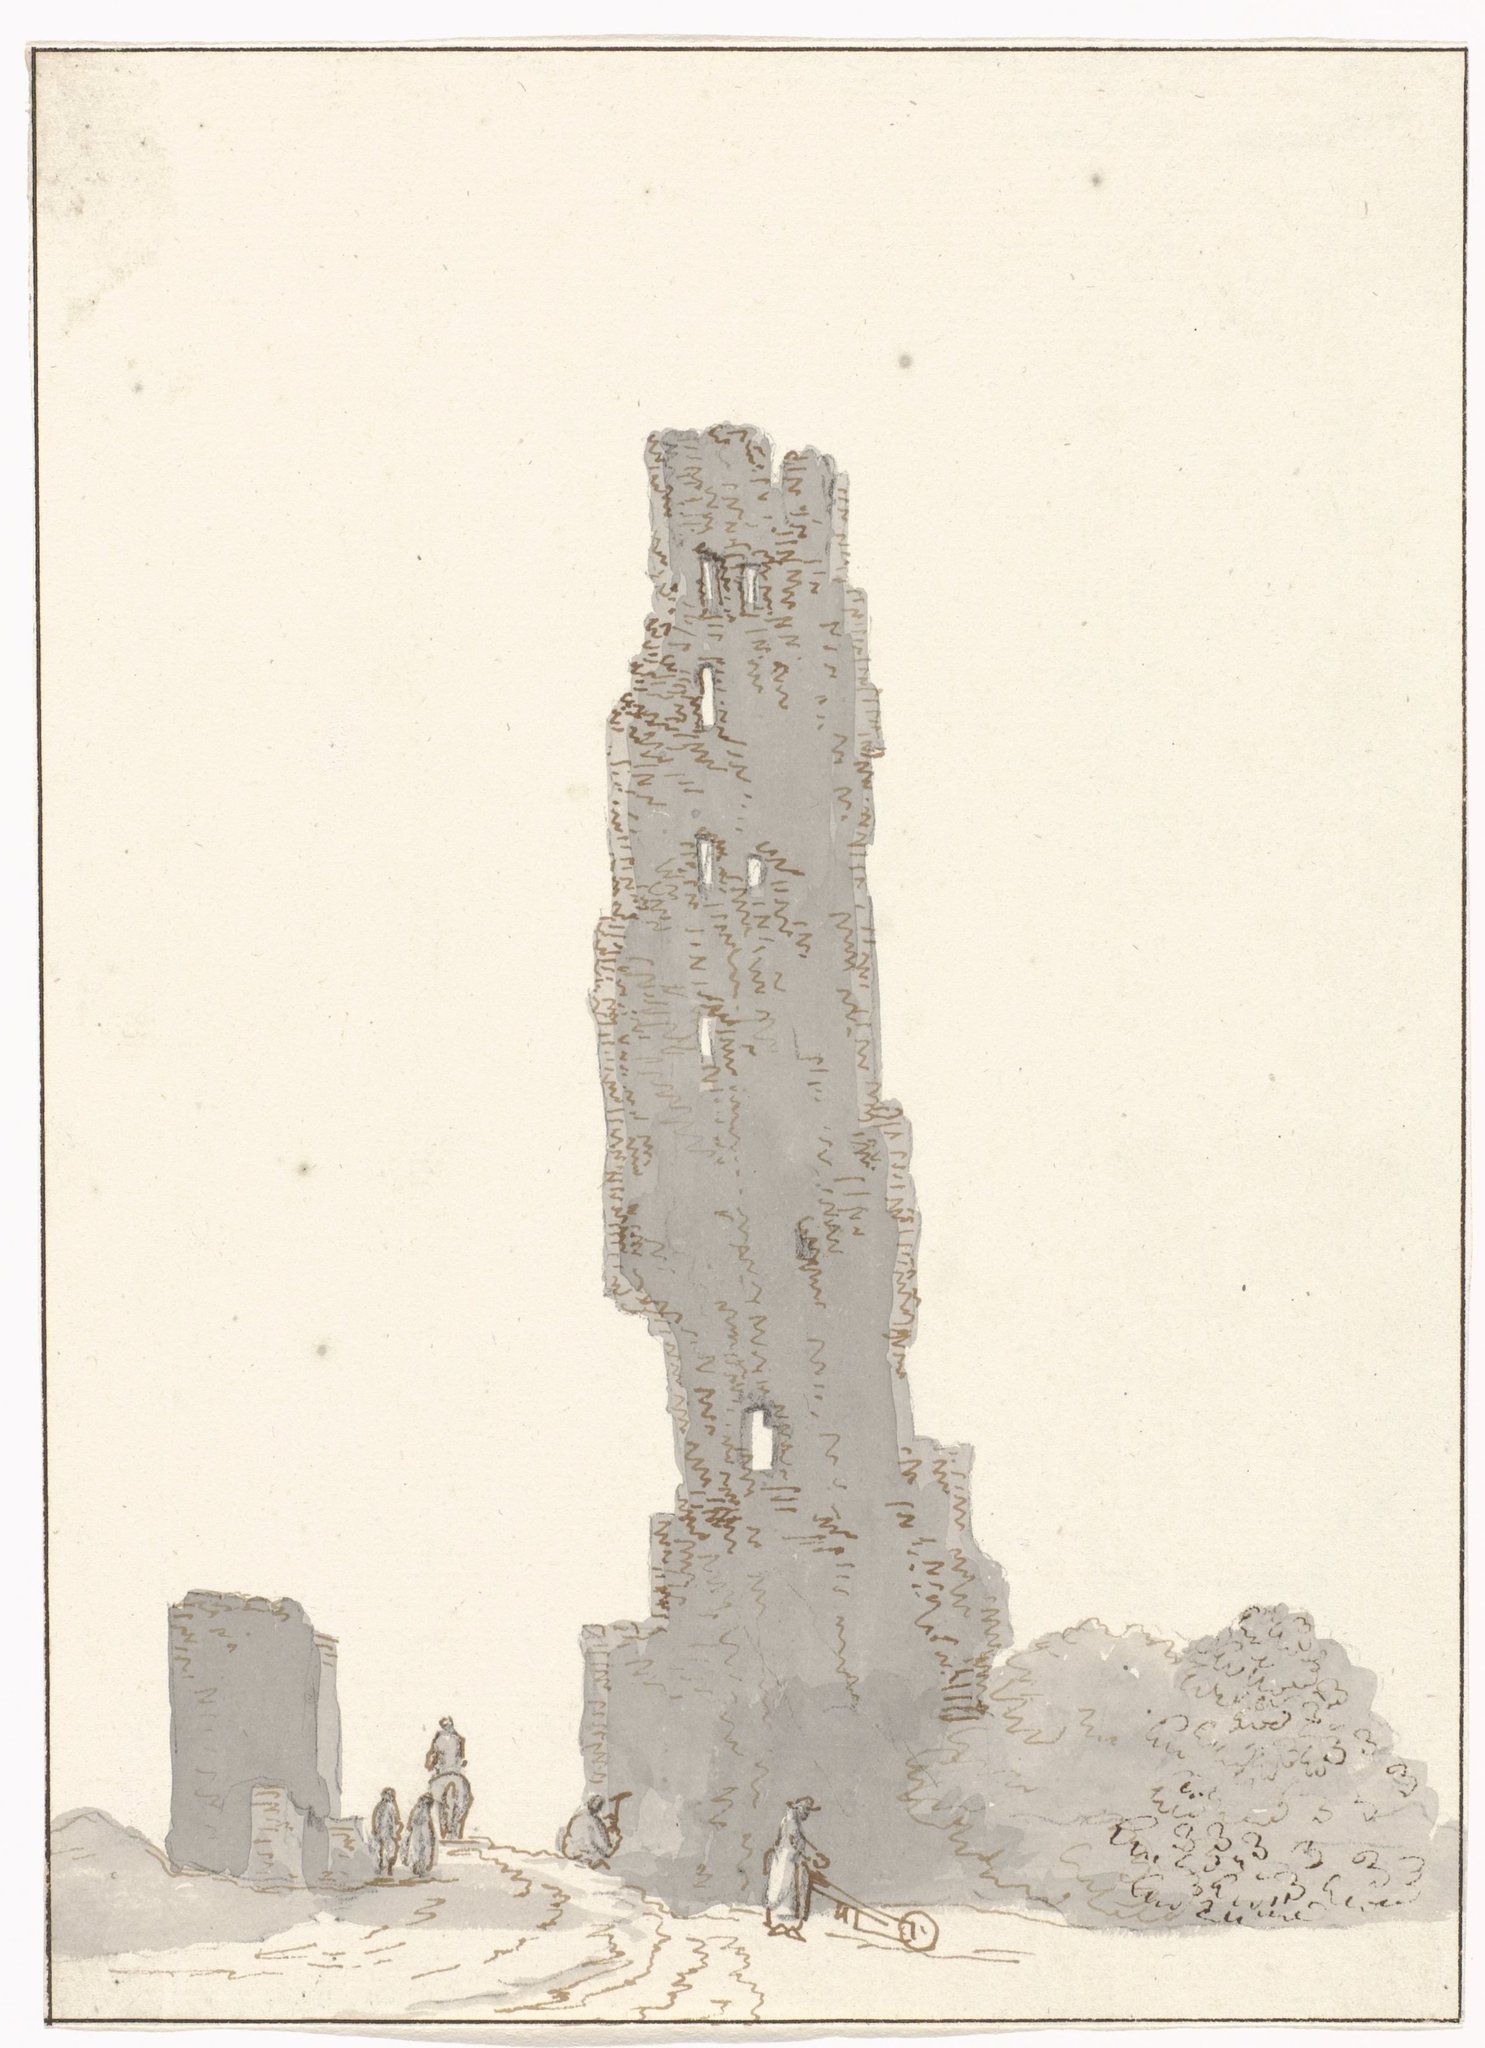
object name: drawing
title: Voyage en Italie, en Sicile et à Malte - 1778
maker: louis ducros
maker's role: draughtsman, print maker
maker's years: 1748-1810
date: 1778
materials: chalk, paper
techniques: brush, pen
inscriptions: number: ‘No 4 Torre delle sette facciate sur le grand chemin entre Terracina & Fondi’